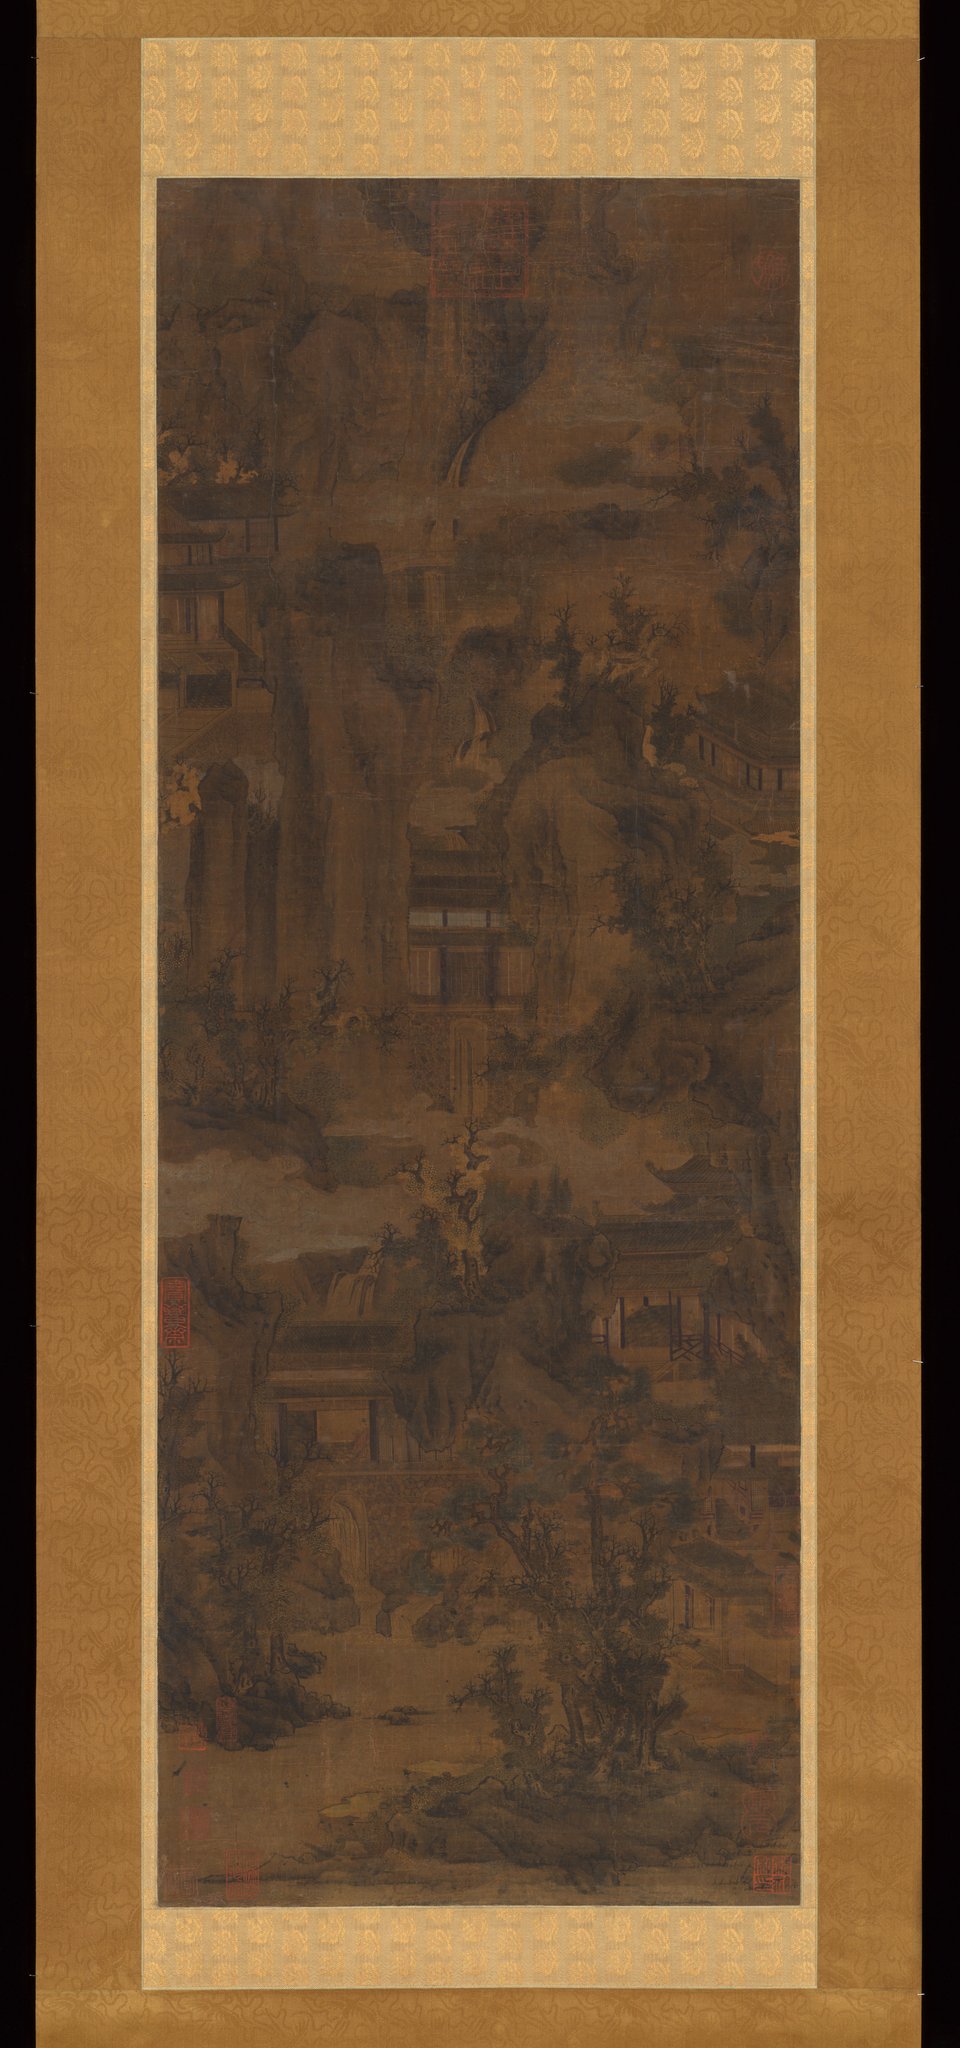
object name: hanging scroll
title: Mountains and Pavilions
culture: chinese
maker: unidentified artist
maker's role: artist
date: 1368-1911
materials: ink, silk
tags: mountains,pavilions